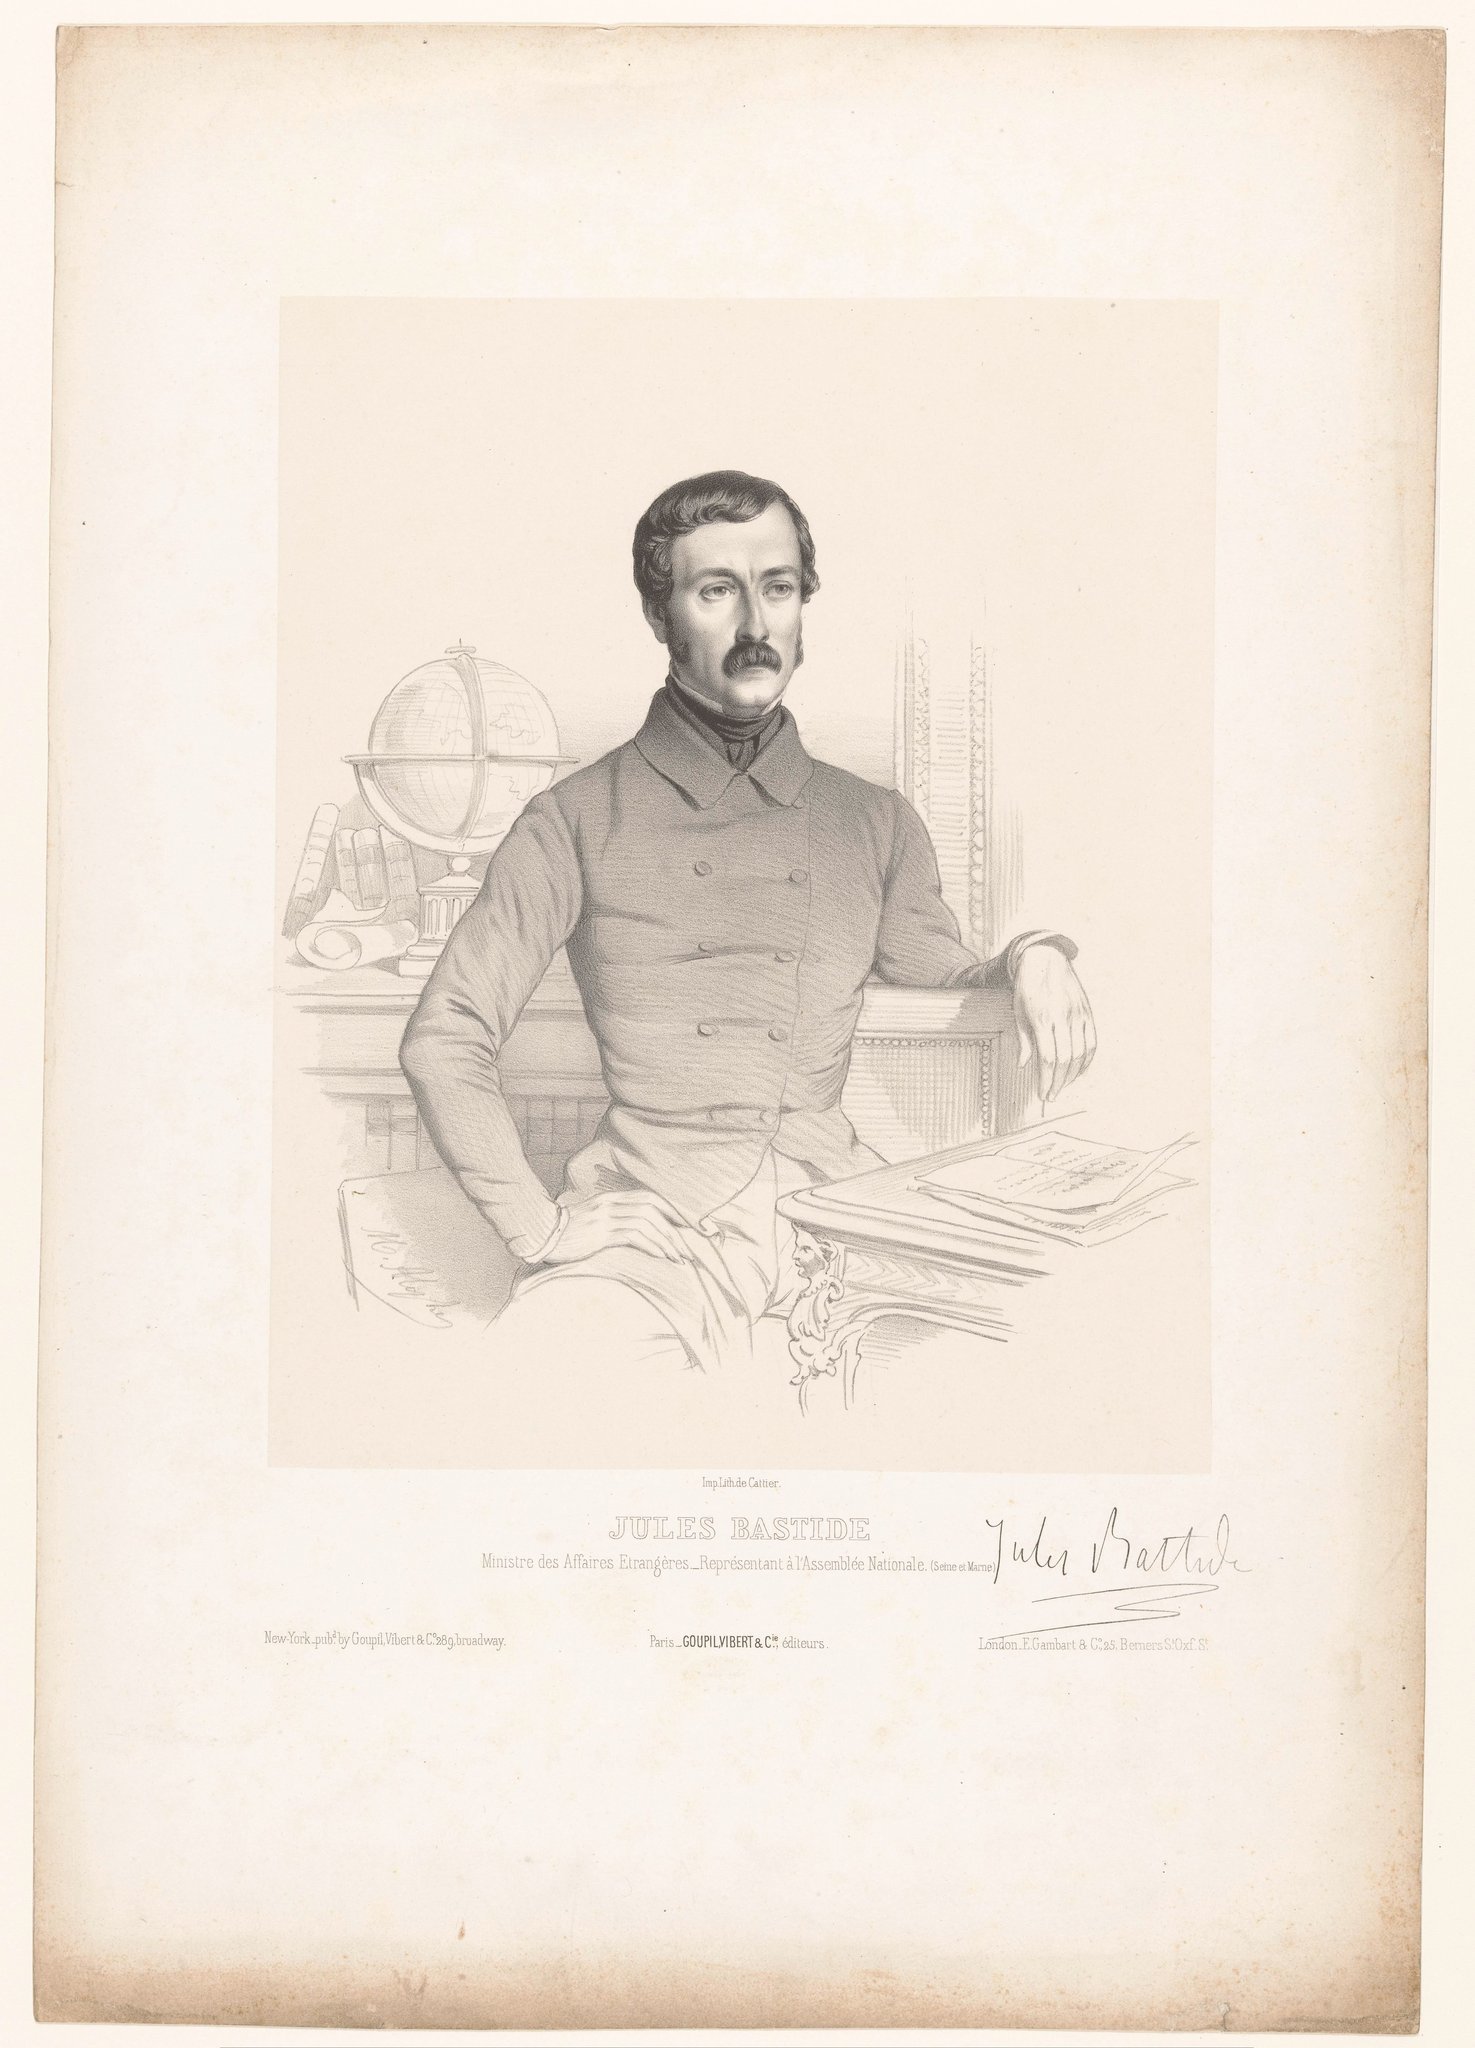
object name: print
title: Jules Bastide. Ministre des affaires etrangères, représentant à l'Assemblée nationale (Seine et Marne)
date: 1848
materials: paper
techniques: lithography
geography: paris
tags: paris, politician, historical persons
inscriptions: collector's mark: Lugt 2228, check stamp: Lugt 5004